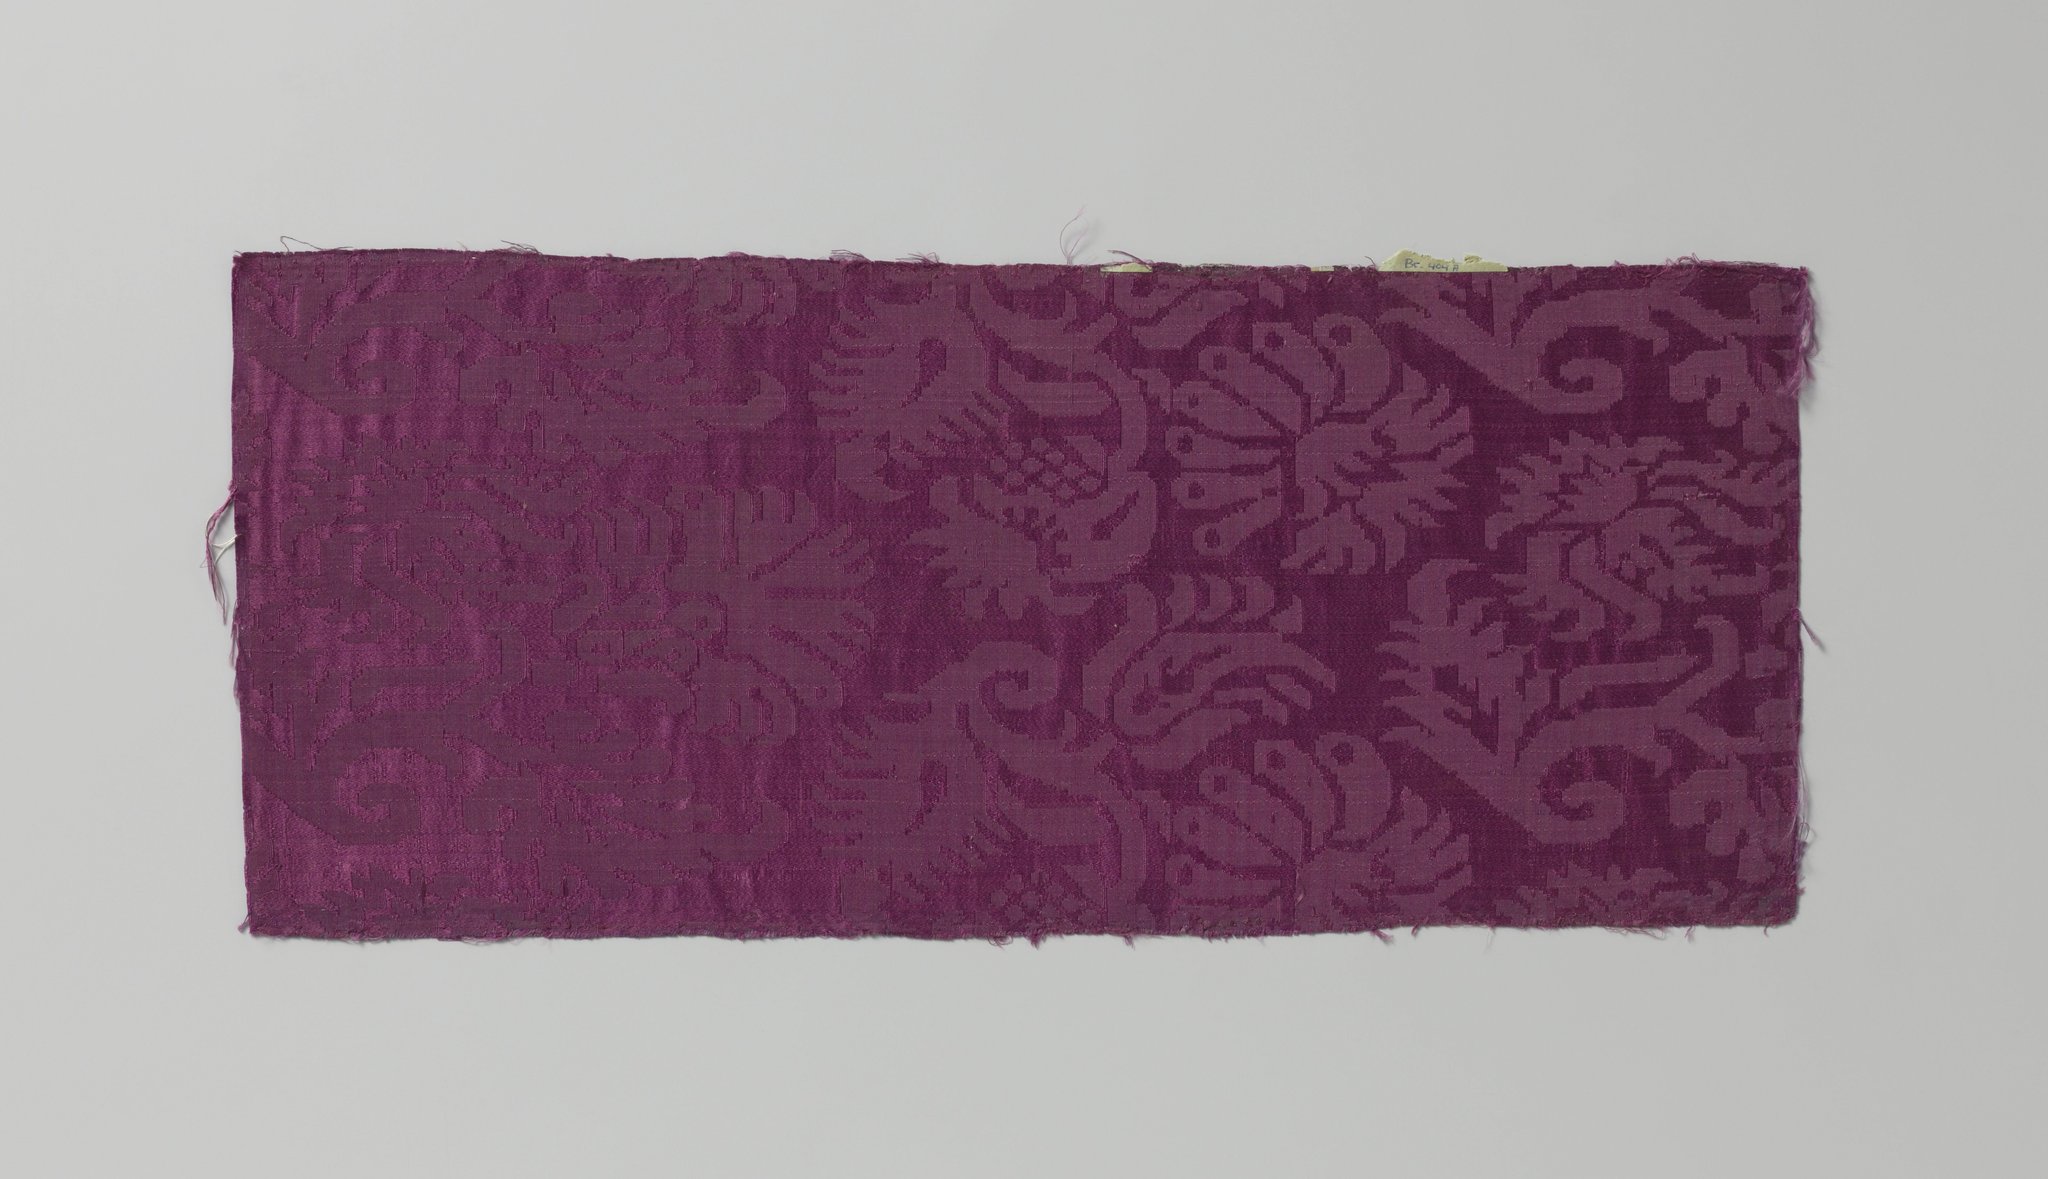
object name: zijdedamast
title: Fragment van paars zijdedamast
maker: Anonymous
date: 1575-1699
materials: silk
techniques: damask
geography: france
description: Een fragment van rood zijdeweefsel. Een gestileerde tekening van bloemen en bladeren.